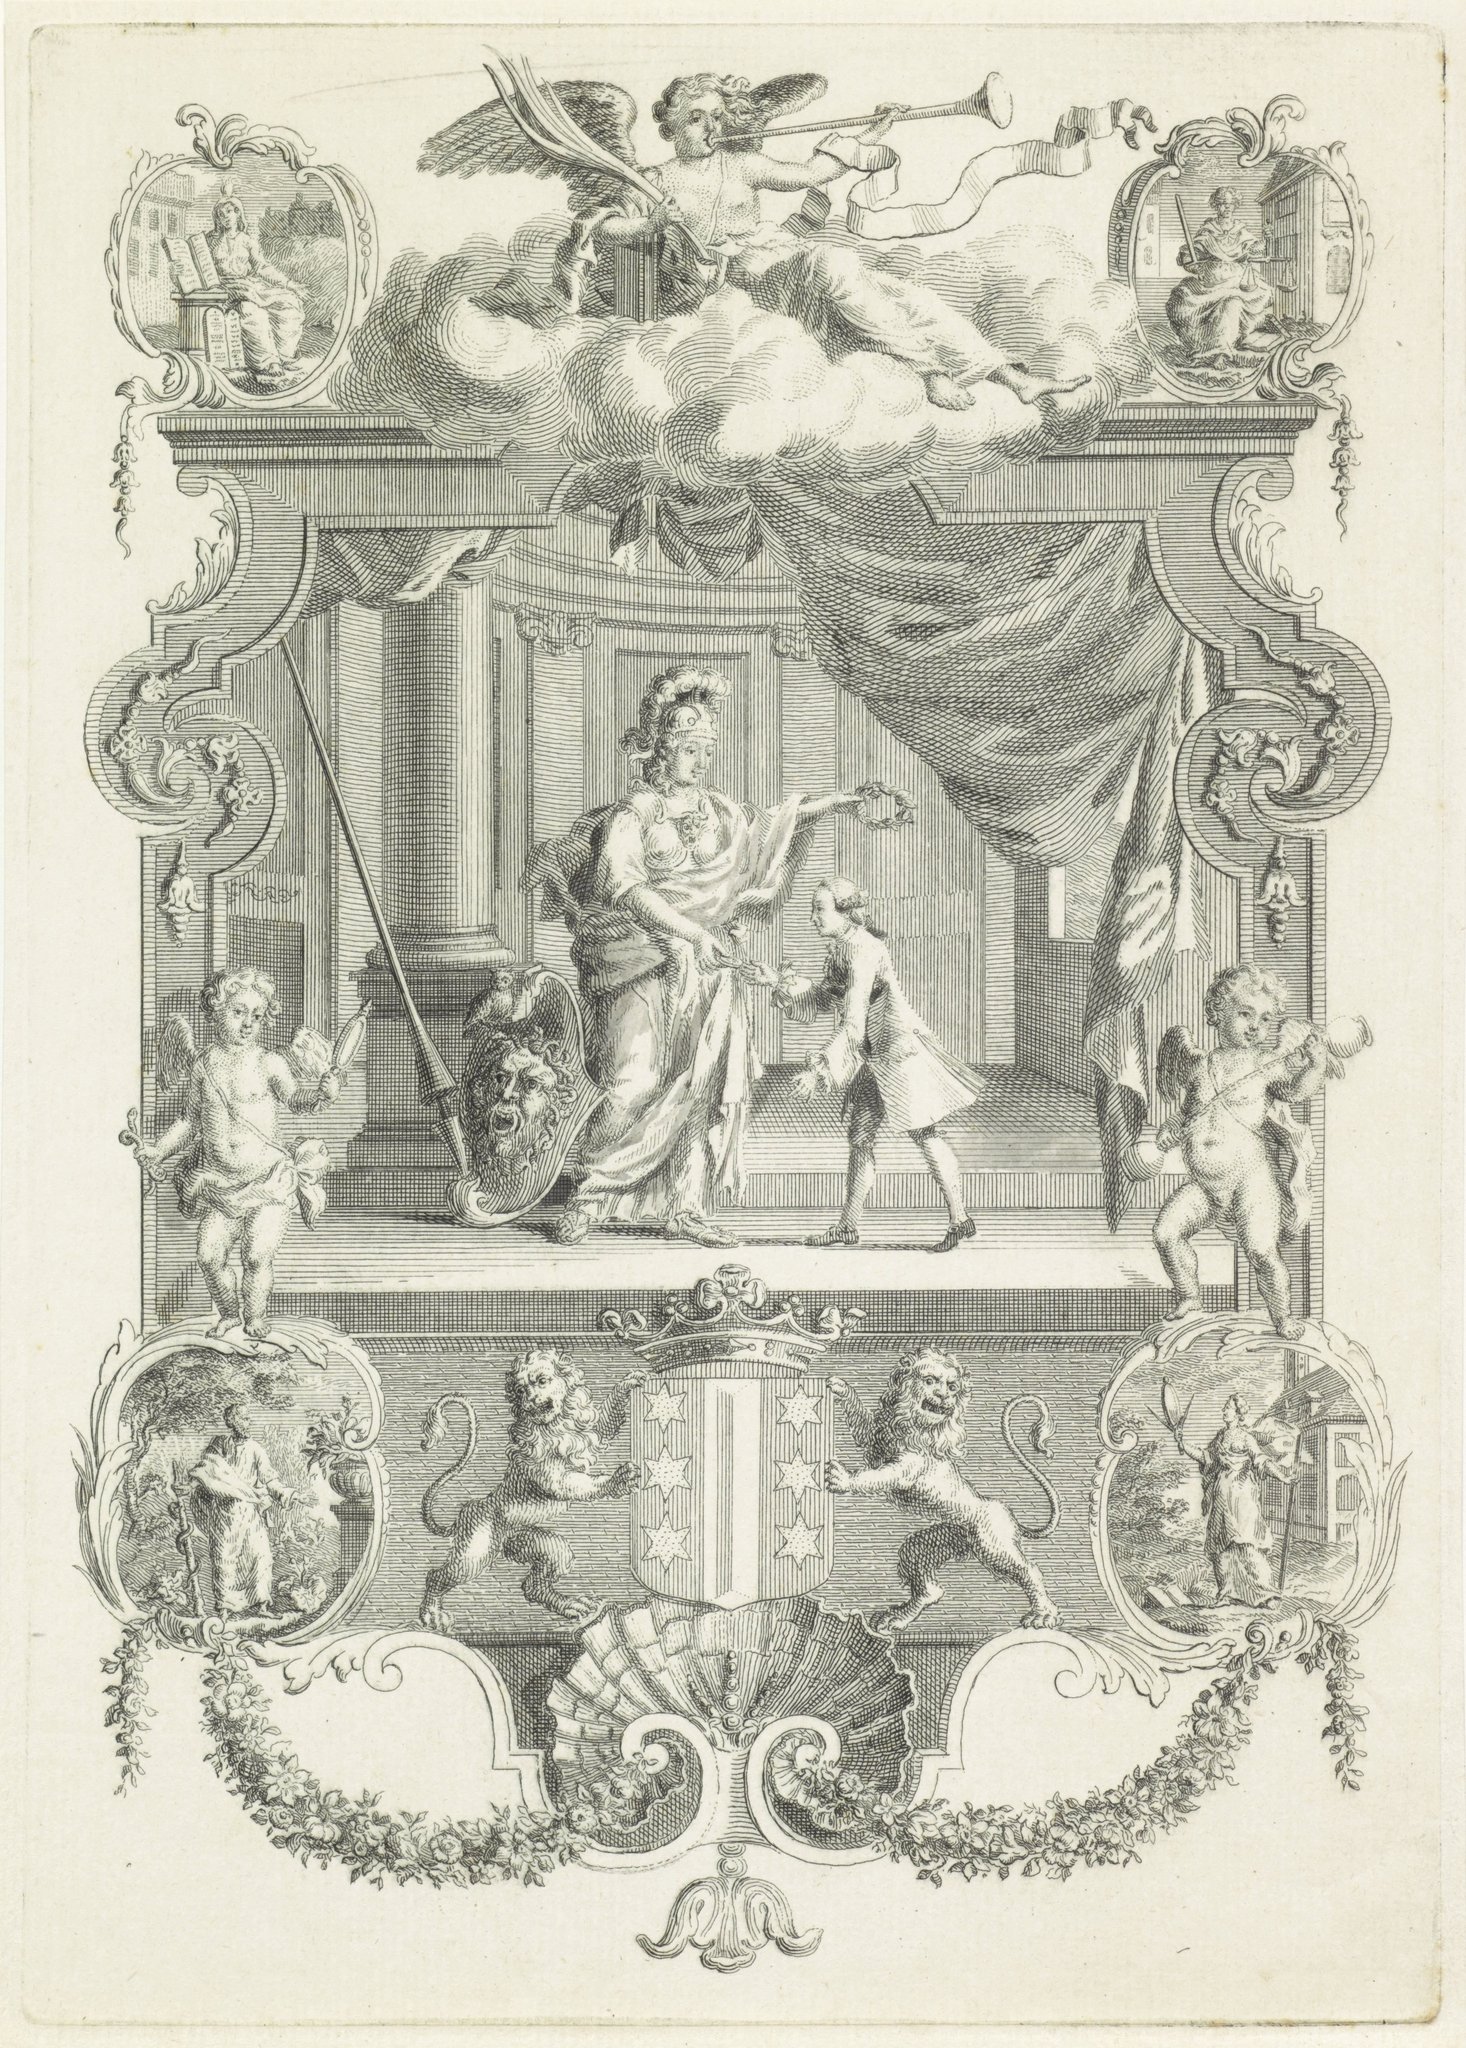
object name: print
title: Allegorie op de stad Gouda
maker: jan wandelaar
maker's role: draughtsman, print maker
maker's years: 1690-1759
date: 1710-1759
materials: paper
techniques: brush, engraving, etching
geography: northern netherlands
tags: justice, 'justitia'; 'giustitia divina' (ripa) ~ one of the four cardinal virtues, specific aspects, allegorical aspects of aesculapius; aesculapius as patron, faith, 'fides'; 'fede', 'fede catholica', 'fede christiana', 'fede christiana catholica' (ripa) ~ one of the three theological virtues, fama as roman personification, specific aspects, allegorical aspects of minerva; minerva as patroness, aegis: shield with gorgon's head (attribute of minerva), gouda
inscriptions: collector's mark: Lugt 240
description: In het midden staat Minerva bij een lans en een schild met het hoofd van Medusa. Op het schild zit een uil. In haar linkerhand houdt ze een lauwerkrans en met haar rechterhand ontvangt ze geld of geeft ze geld aan de jonge man voor haar. De voorstelling is in een ornamentele omlijsting gevat. Boven de voorstelling zit de gevleugelde Faam met een bazuin en een palmtak. Linksboven zit de personificatie van het geloof in de gedaante van een vrouw met een vlam op haar hoofd bij twee stenen tafelen. Ze houdt een geschrift in haar hand. Rechts naast Faam zit Justitia. Linksonder staat een putto met een slang en een spiegel, symbolen van voorzichtigheid, op een floraal medaillon met daarin Aesculapius, de god van de geneeskunde. Rechts staat een putto, die water overgiet van de ene kruik in de andere kruik als symbool van matigheid. Hij staat op een floraal medaillon met daarin een vrouw met een spiegel, een passer en een lat, mogelijk de personificatie van meetkunde of astronomie. Midden onder het stadswapen van Gouda.